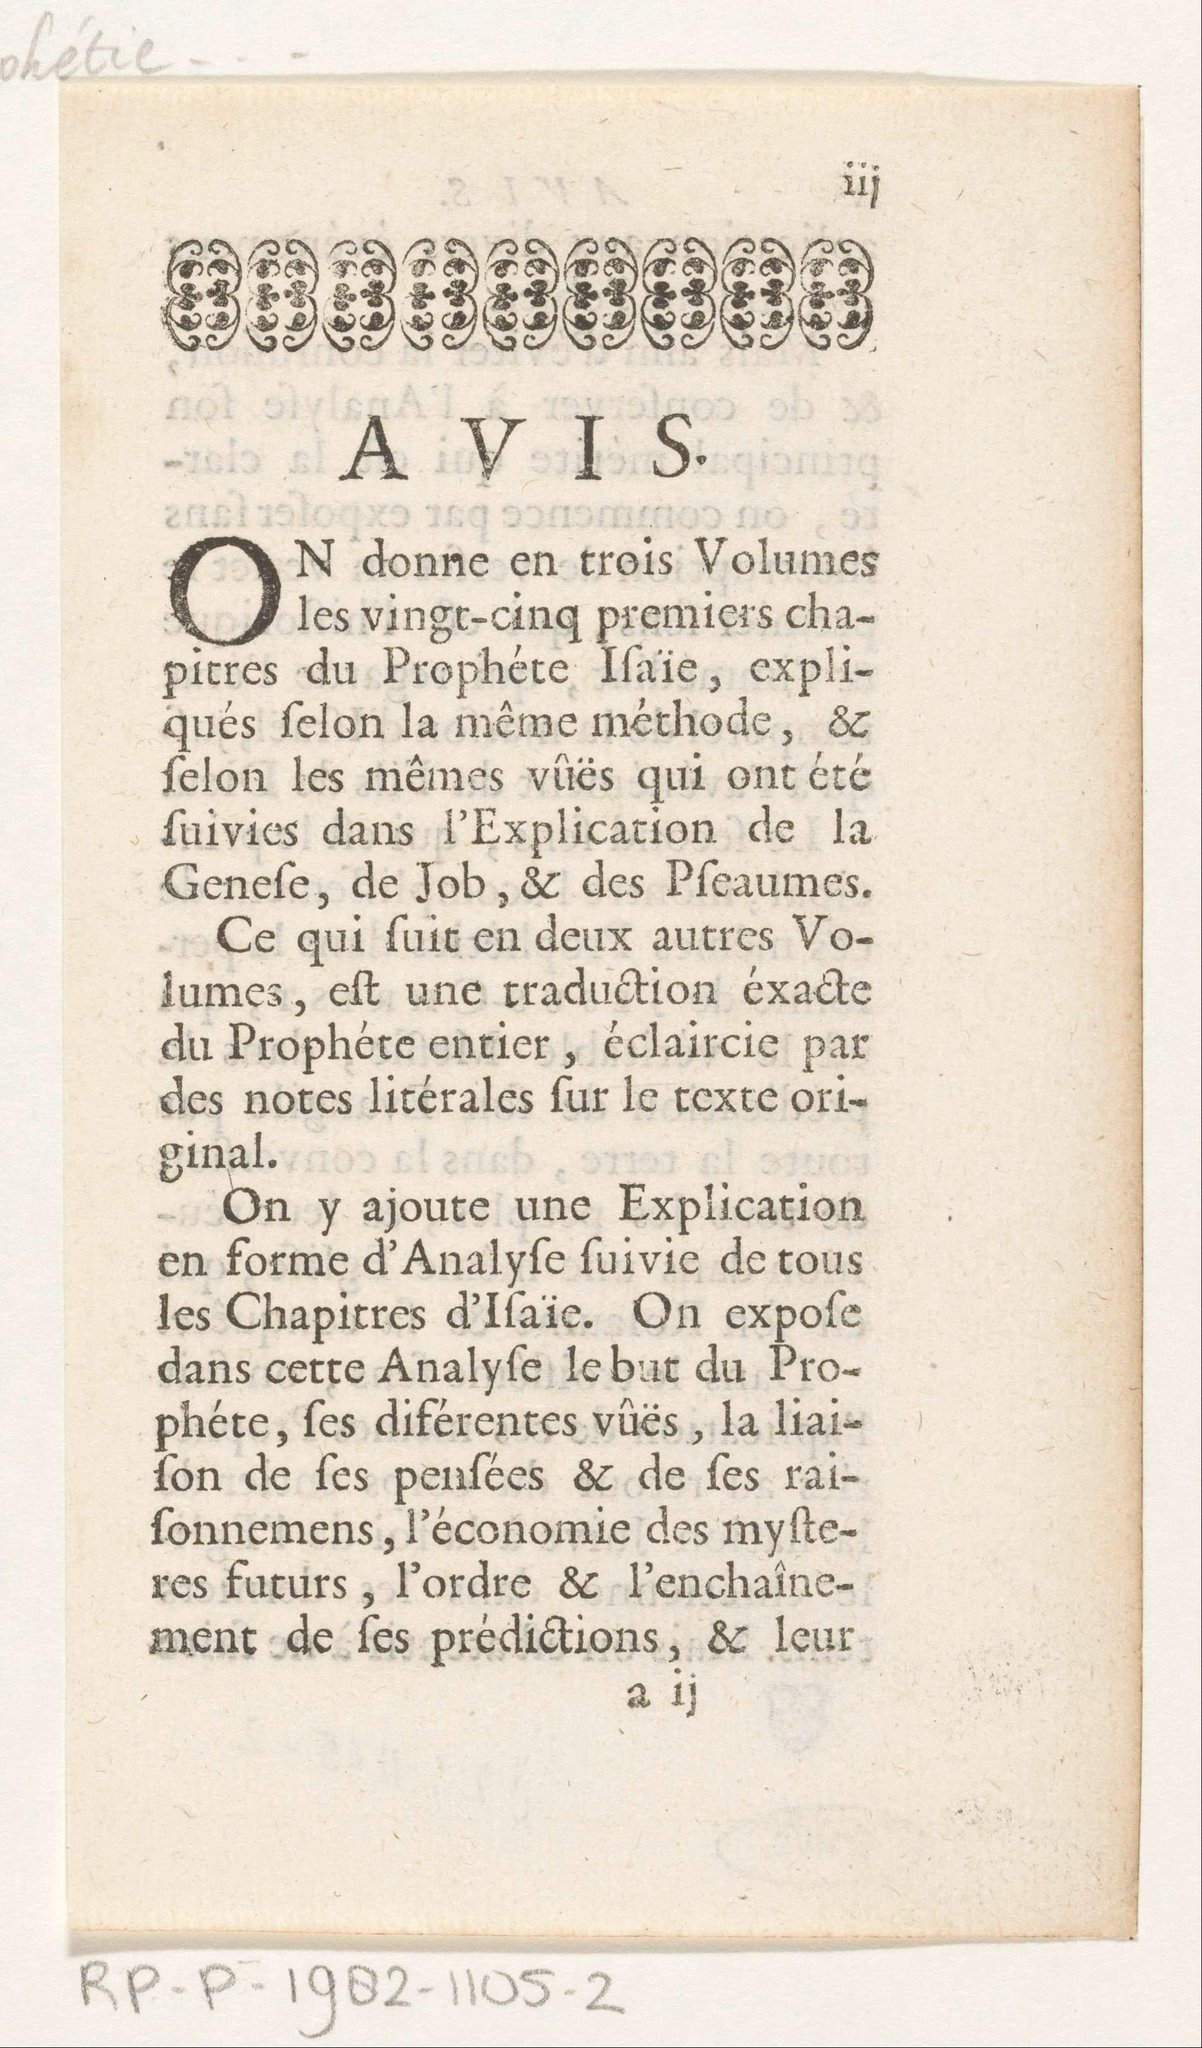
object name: print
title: Tekstblad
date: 1734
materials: paper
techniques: letterpress printing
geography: paris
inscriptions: collector's mark: Lugt 2228, collector's mark: Lugt 2760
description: Tekstblad uit: S.n. Explication de la prophétie d'Isaïe, Tome premier. Parijs: Babuty, François, 1734.